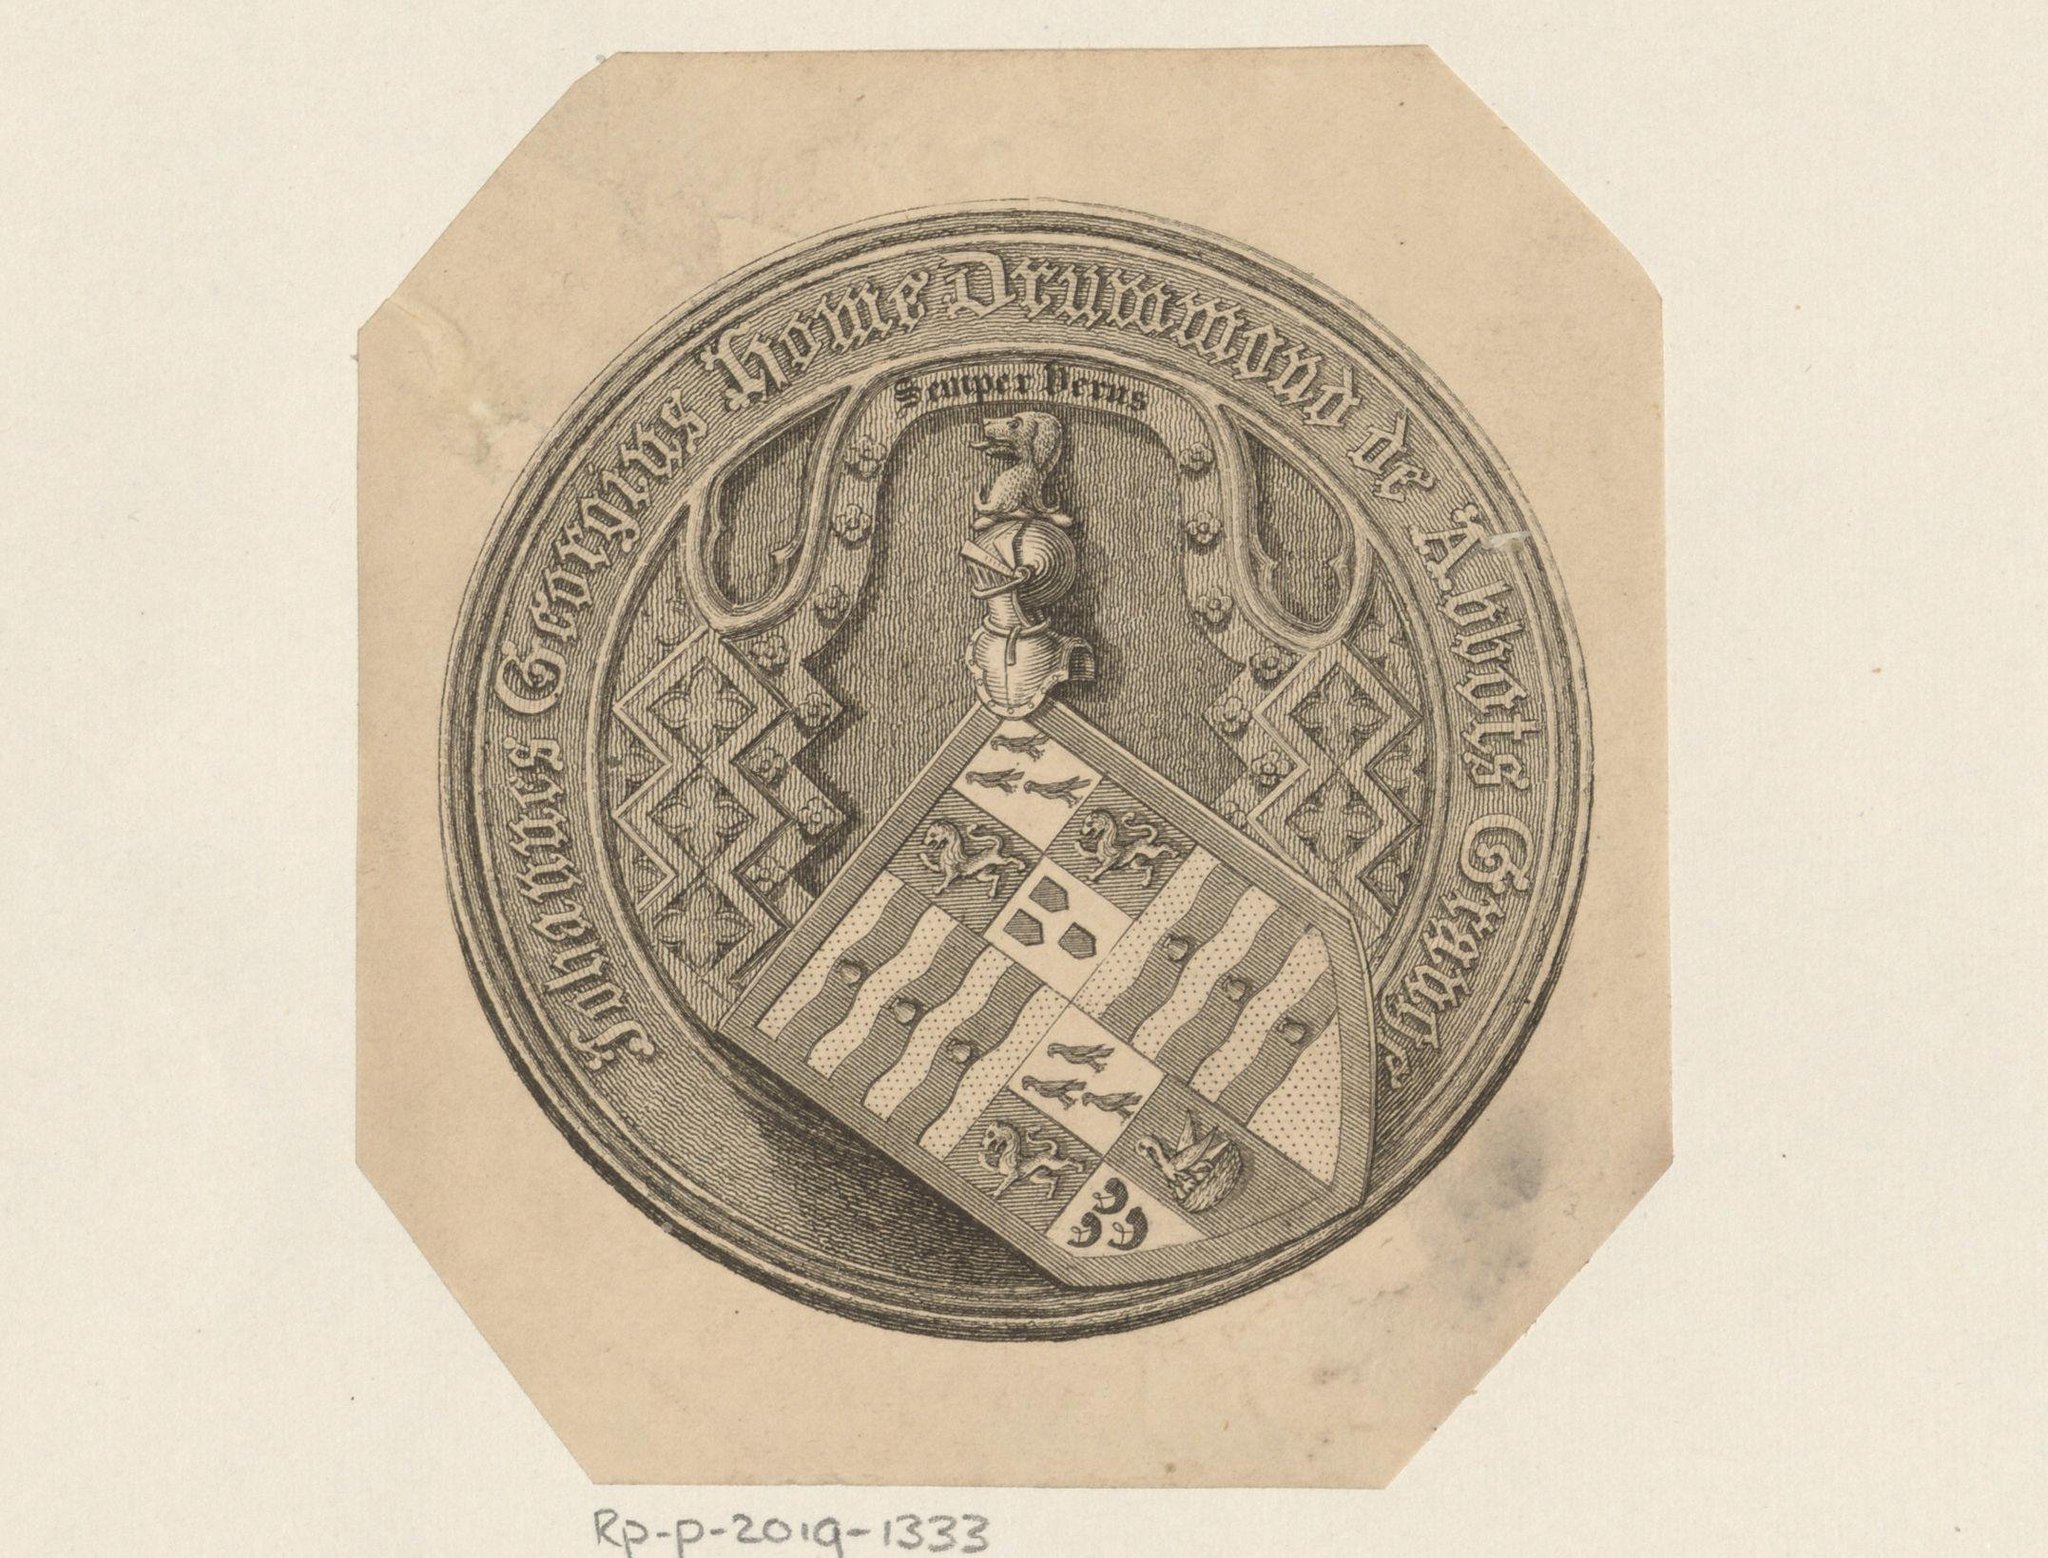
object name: bookplate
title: Semper herus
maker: Anonymous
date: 1800-1899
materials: paper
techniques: engraving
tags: armorial bearing, heraldry